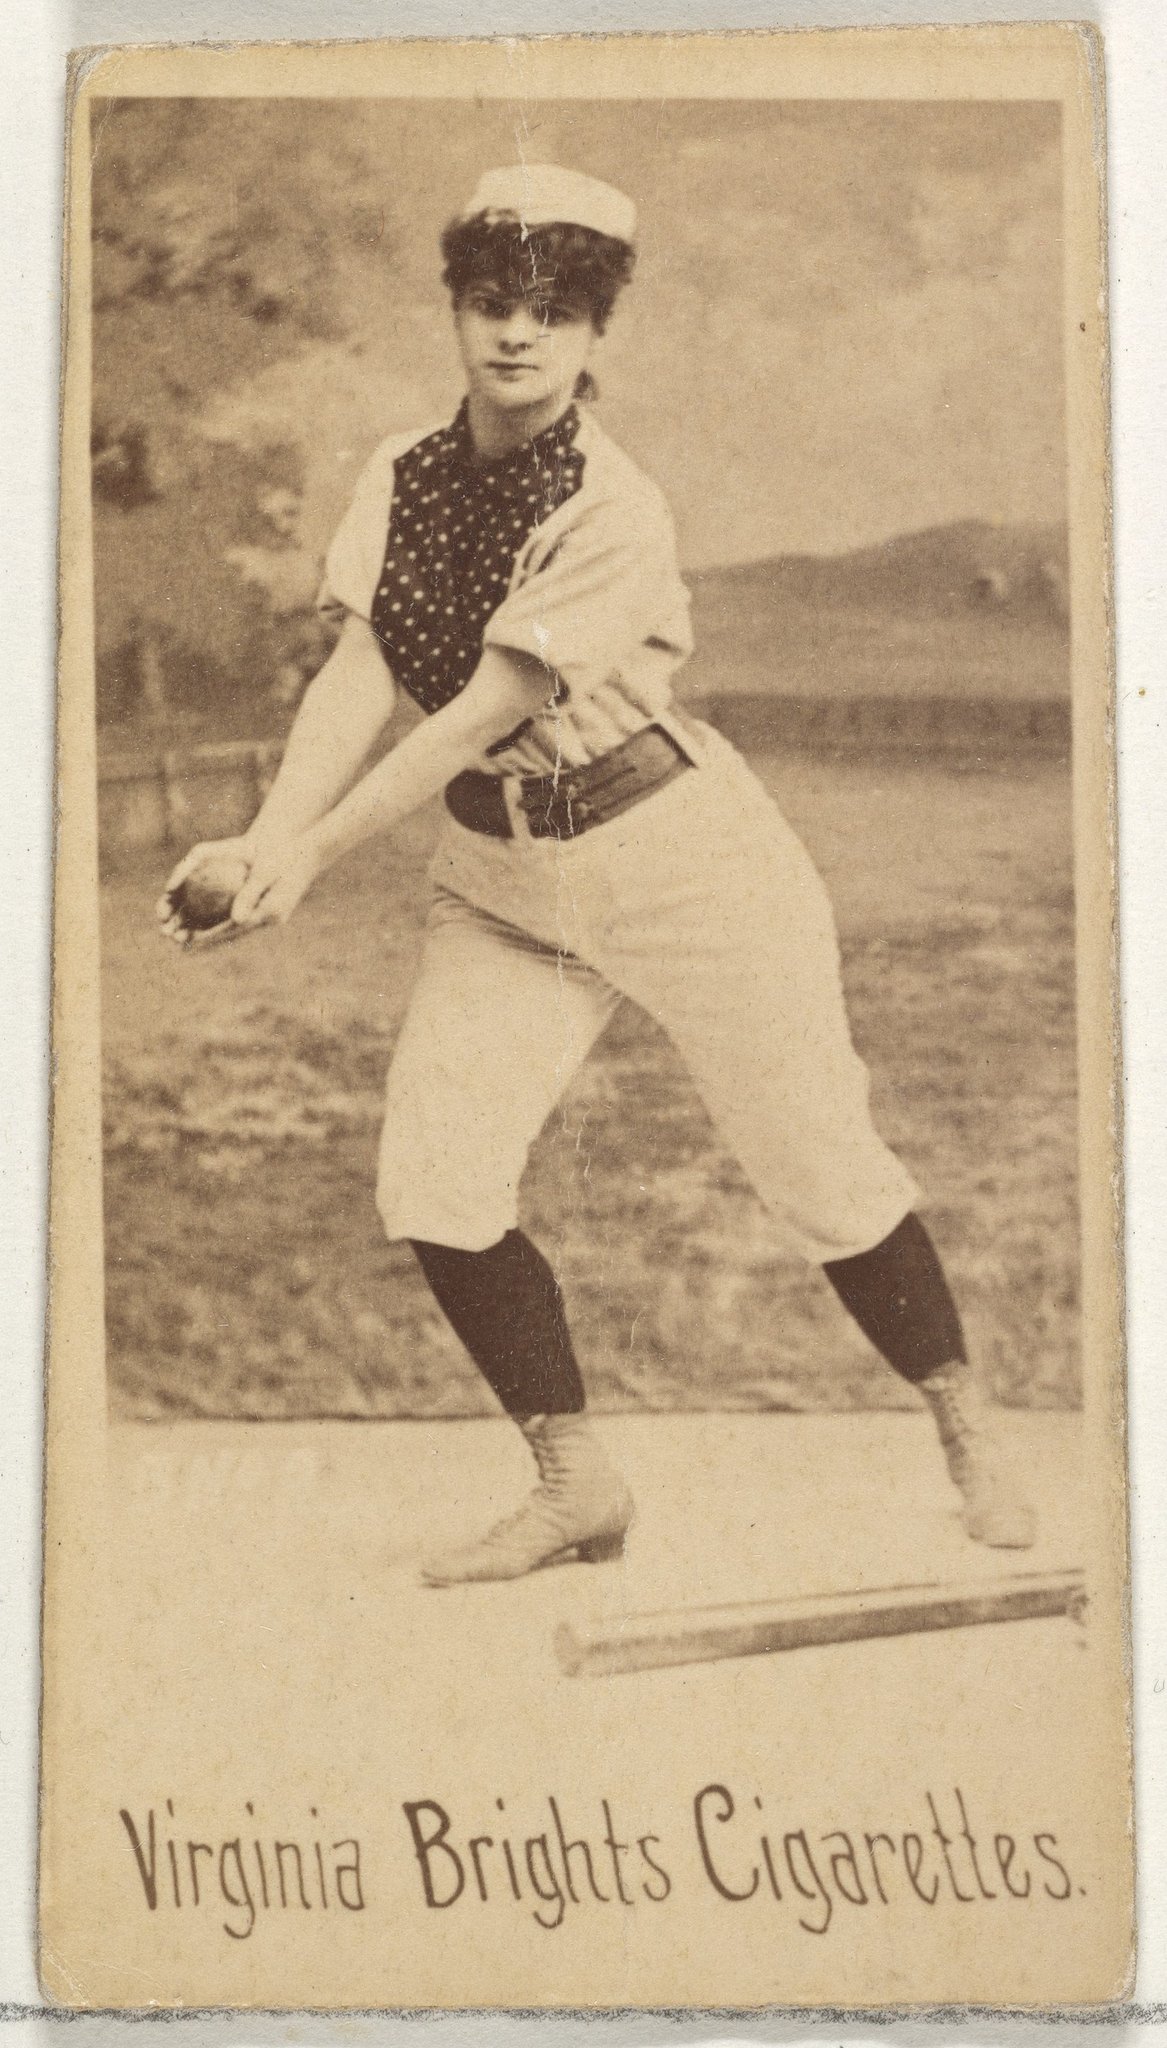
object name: baseball card, photograph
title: From the Girl Baseball Players series (N48, Type 1) for Virginia Brights Cigarettes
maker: allen & ginter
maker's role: publisher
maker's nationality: american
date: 1886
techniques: albumen silver print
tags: portraits,women,baseball,athletes